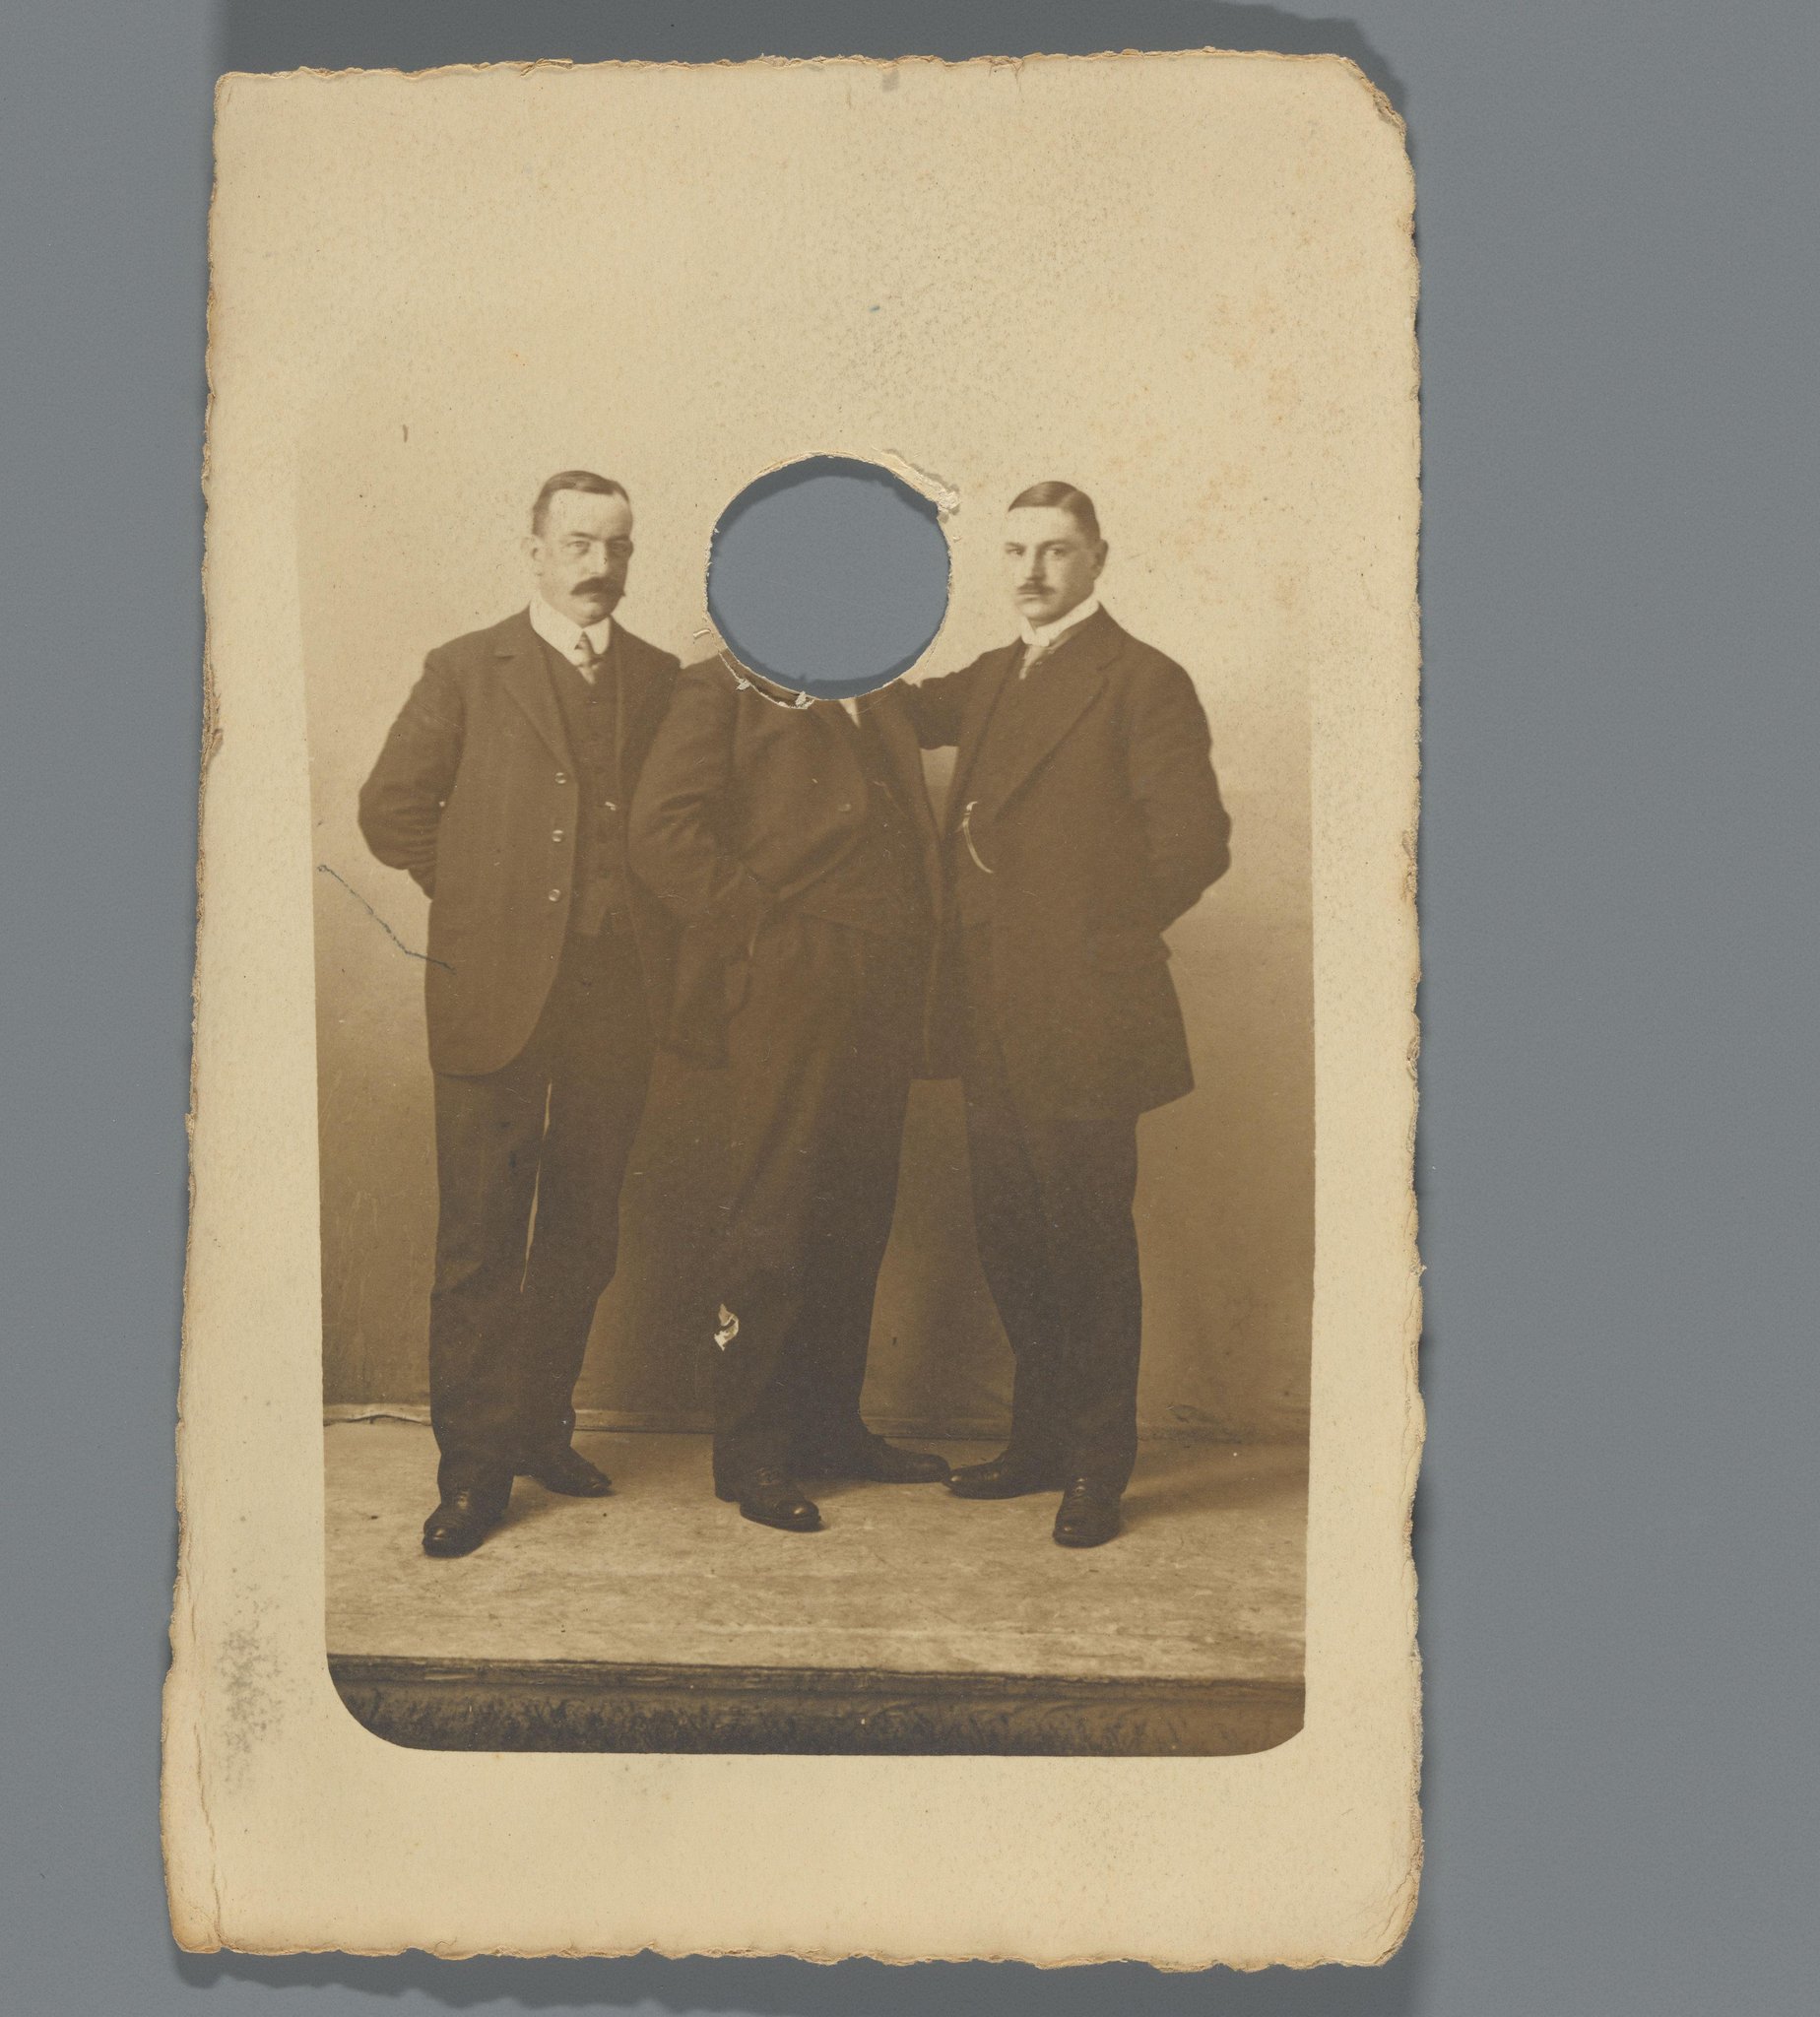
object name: ansichtkaart, prentbriefkaart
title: Groepsportret van drie onbekende mannen, één weggeknipt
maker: Anonymous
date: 1890-1930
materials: paper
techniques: gelatin silver print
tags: anonymous historical persons portrayed in a group, in a group-portrait